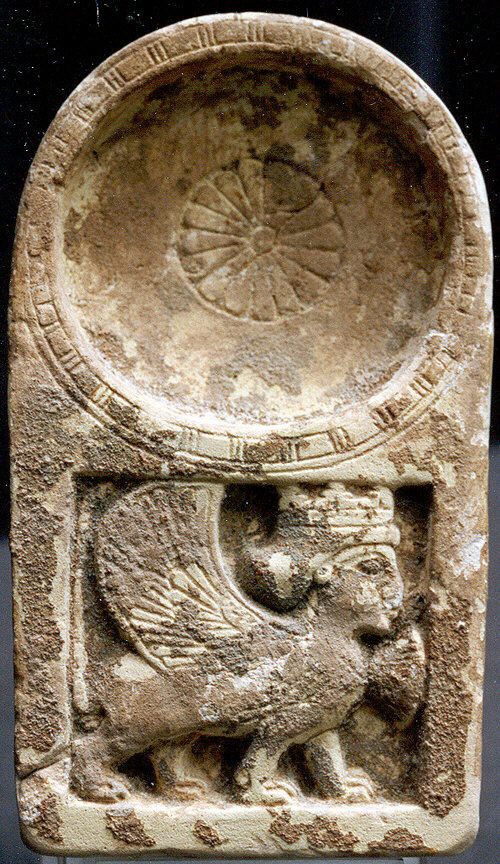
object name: cosmetic tray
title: Cosmetic tray with sphinx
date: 600-401 BCE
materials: limestone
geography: egypt or iran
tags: sphinx